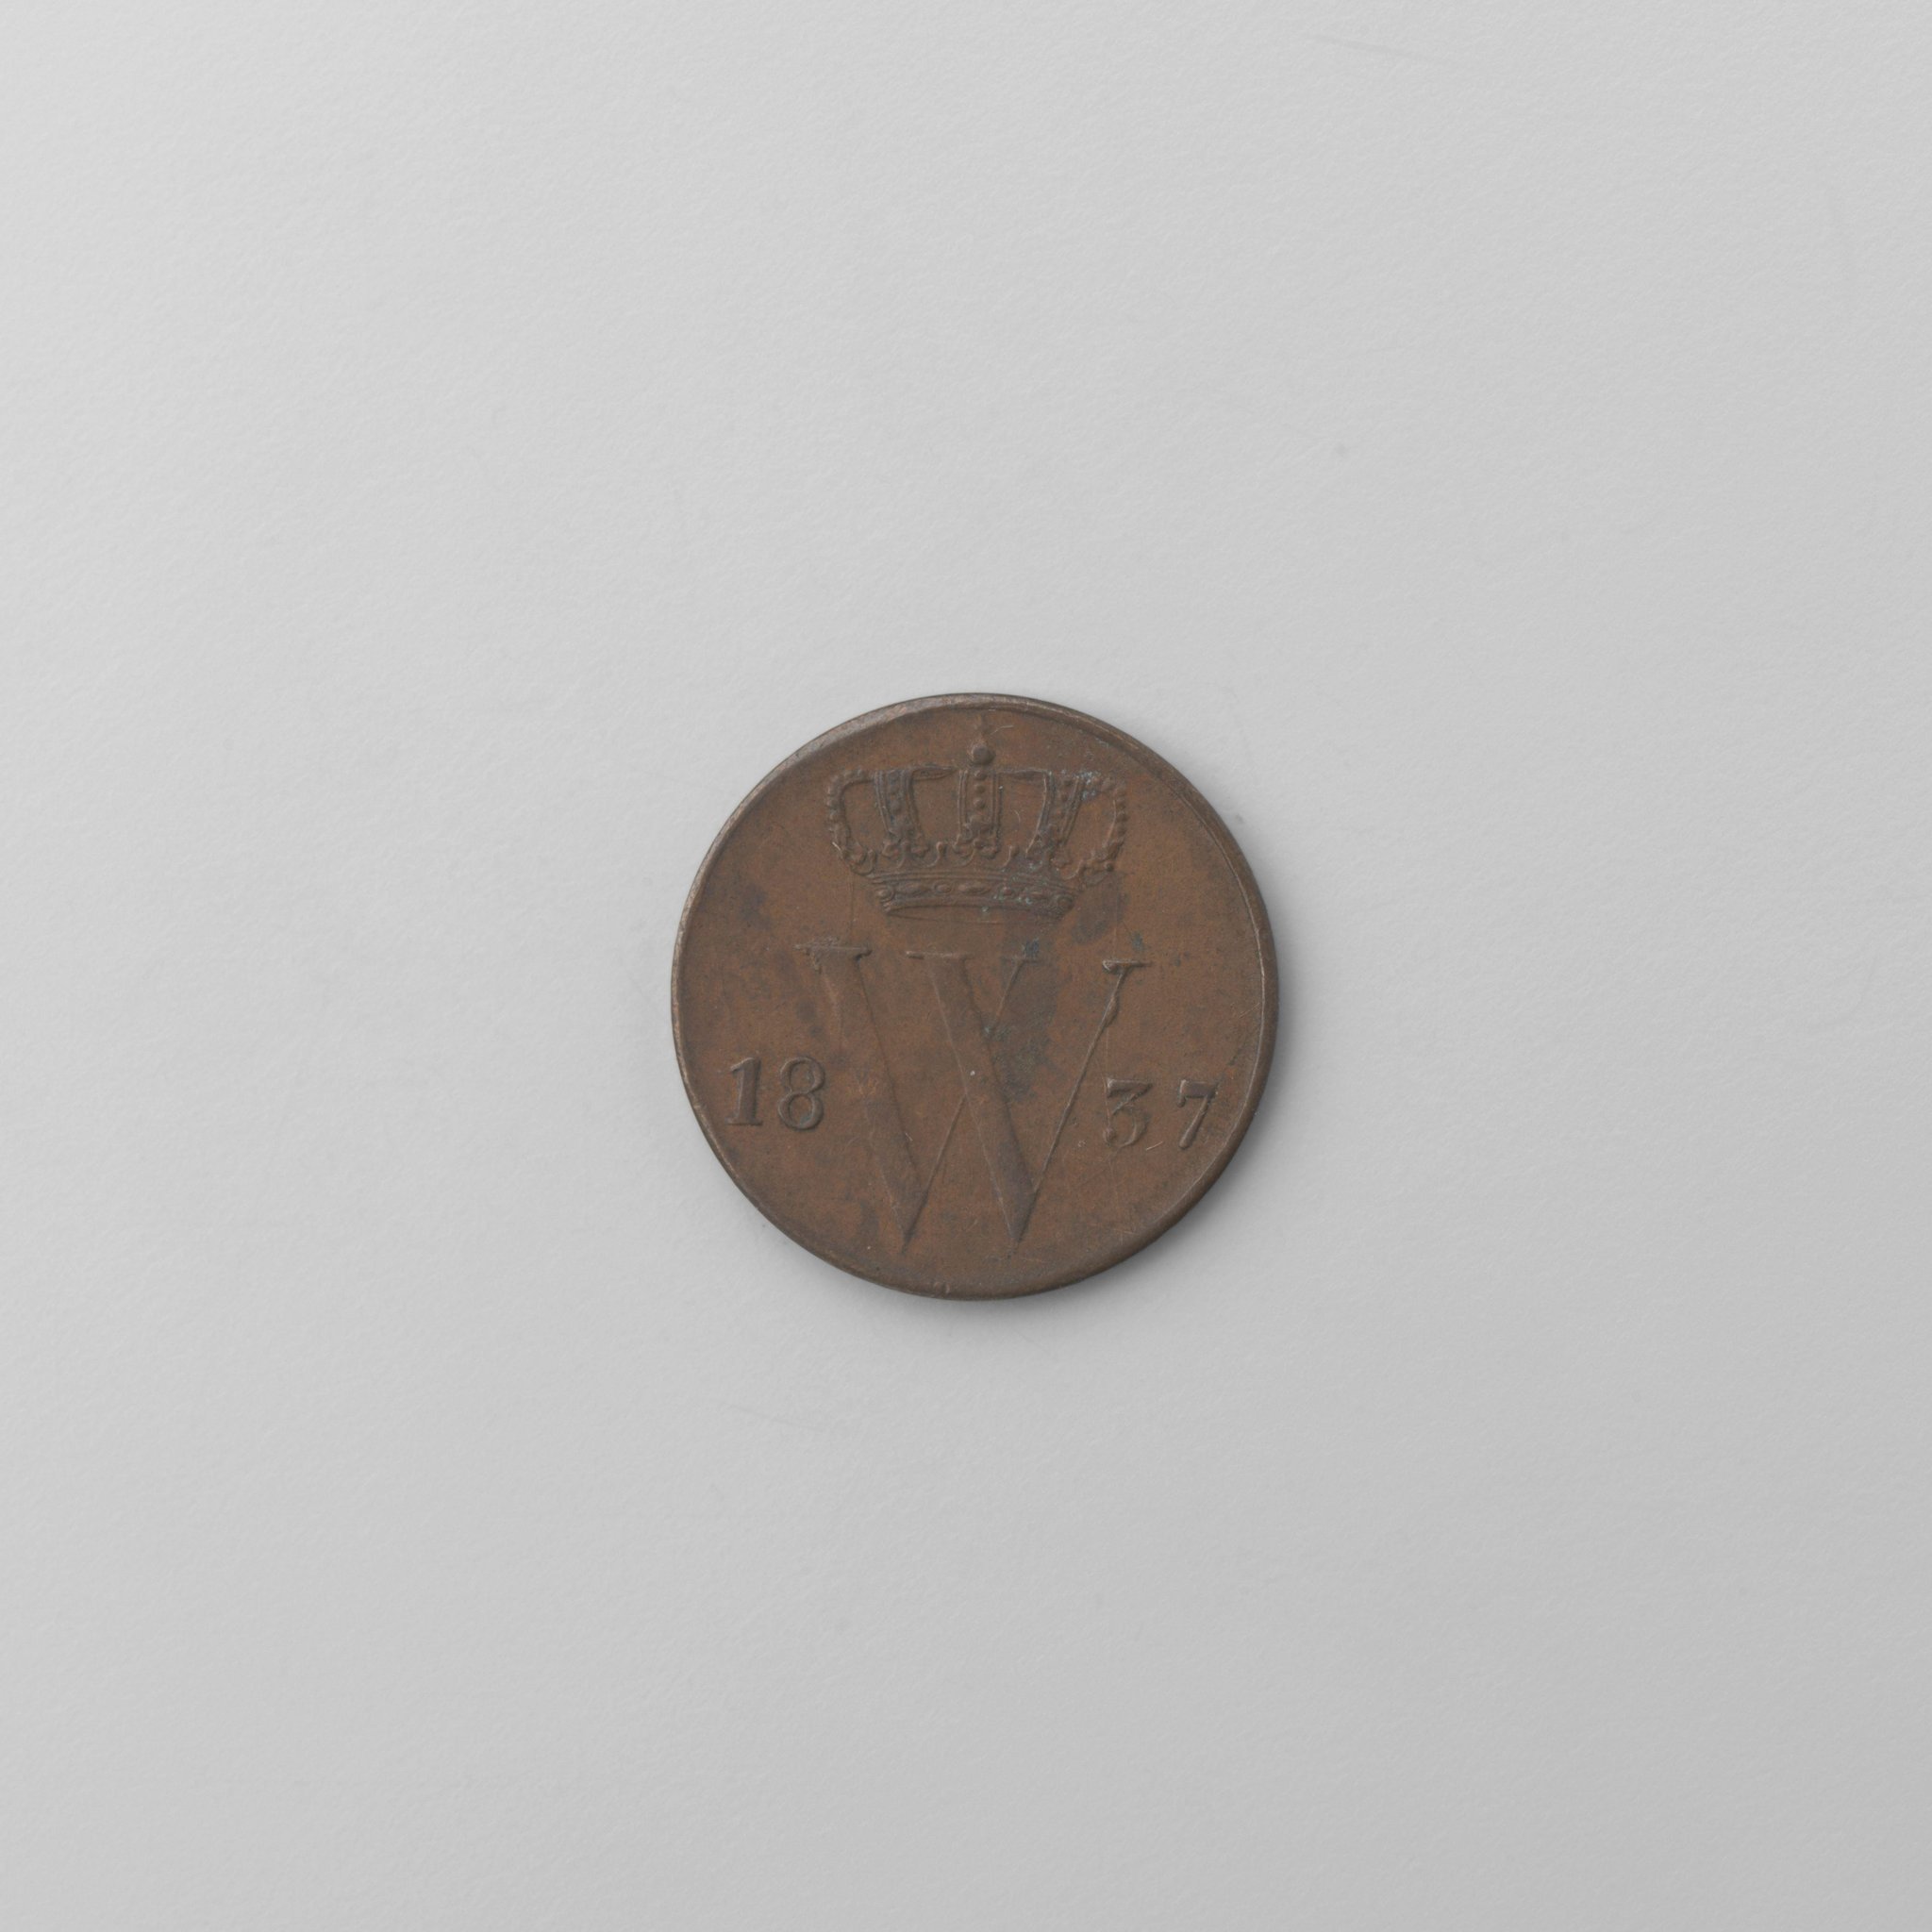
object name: coin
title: Nederland, ½ cent, 1837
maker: william i of the netherlands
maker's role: koning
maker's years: 1772-1843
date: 1837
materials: copper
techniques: striking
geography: utrecht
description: Koperen munt. Voorzijde: tussen jaartal gekroonde rechte letter W. Keerzijde: tussen waarde-aanduiding ½ C. gekroond rijkswapenschild. Gladde rand.